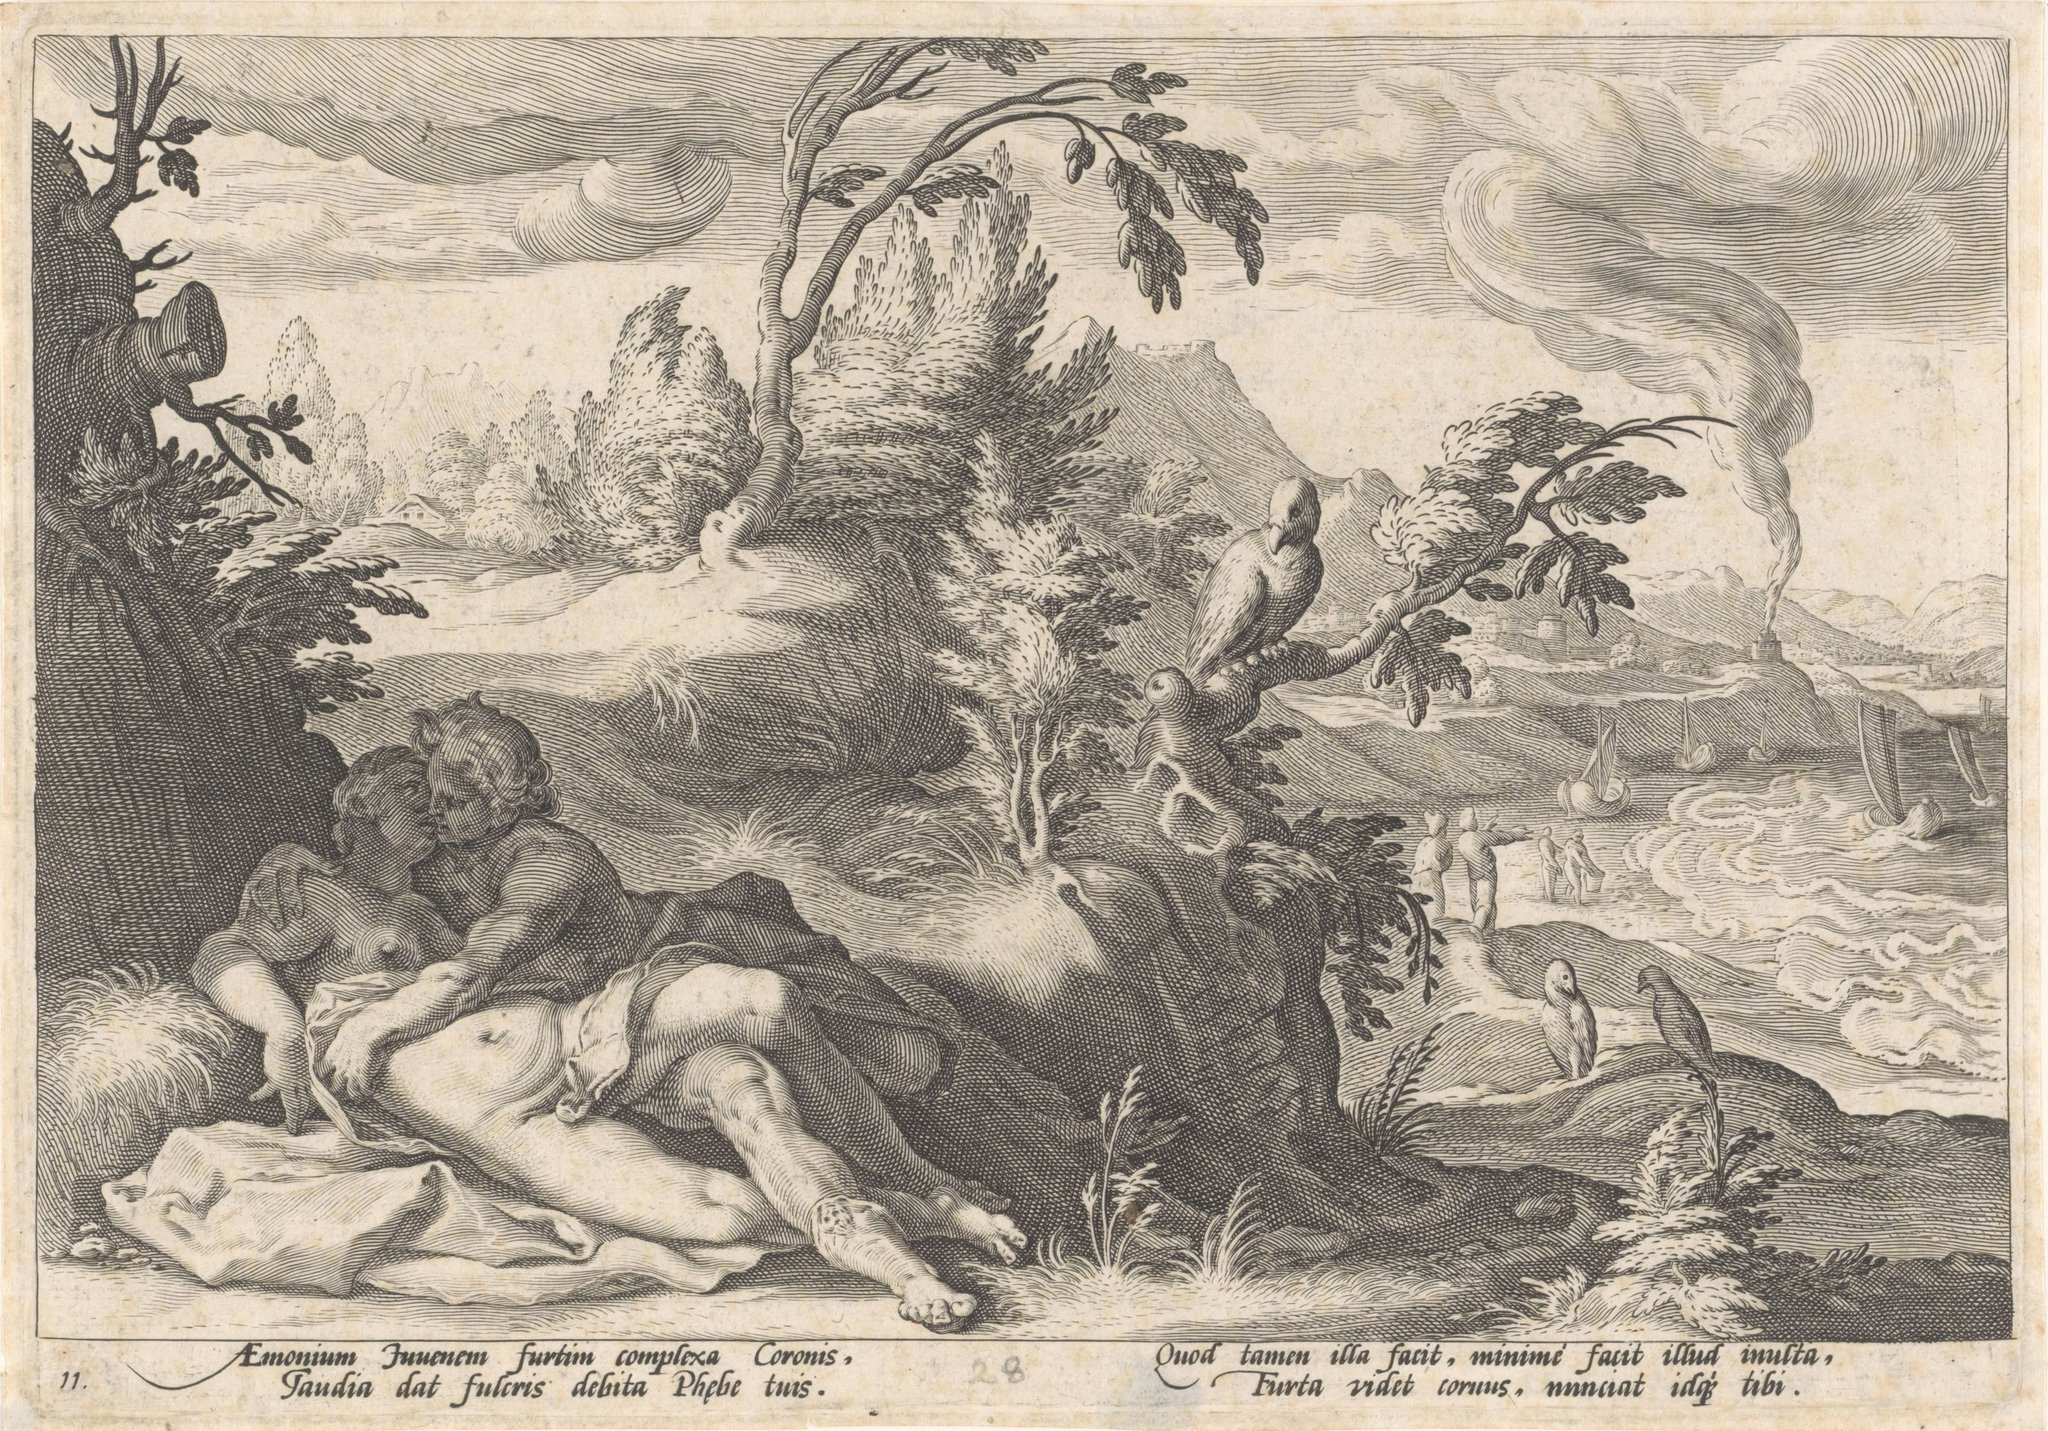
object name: print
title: Apollo en Coronis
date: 1590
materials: paper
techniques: engraving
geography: haarlem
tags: apollo wooing coronis, daughter of king phlegyas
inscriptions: collector's mark: ‘Hinloopen’, collector's mark: Lugt 11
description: Apollo kust Coronis onder het toeziend oog van een witte kraai. Op de achtergrond een kustlandschap. In de ondermarge een vierregelige toelichting, in twee kolommen, in het Latijn.